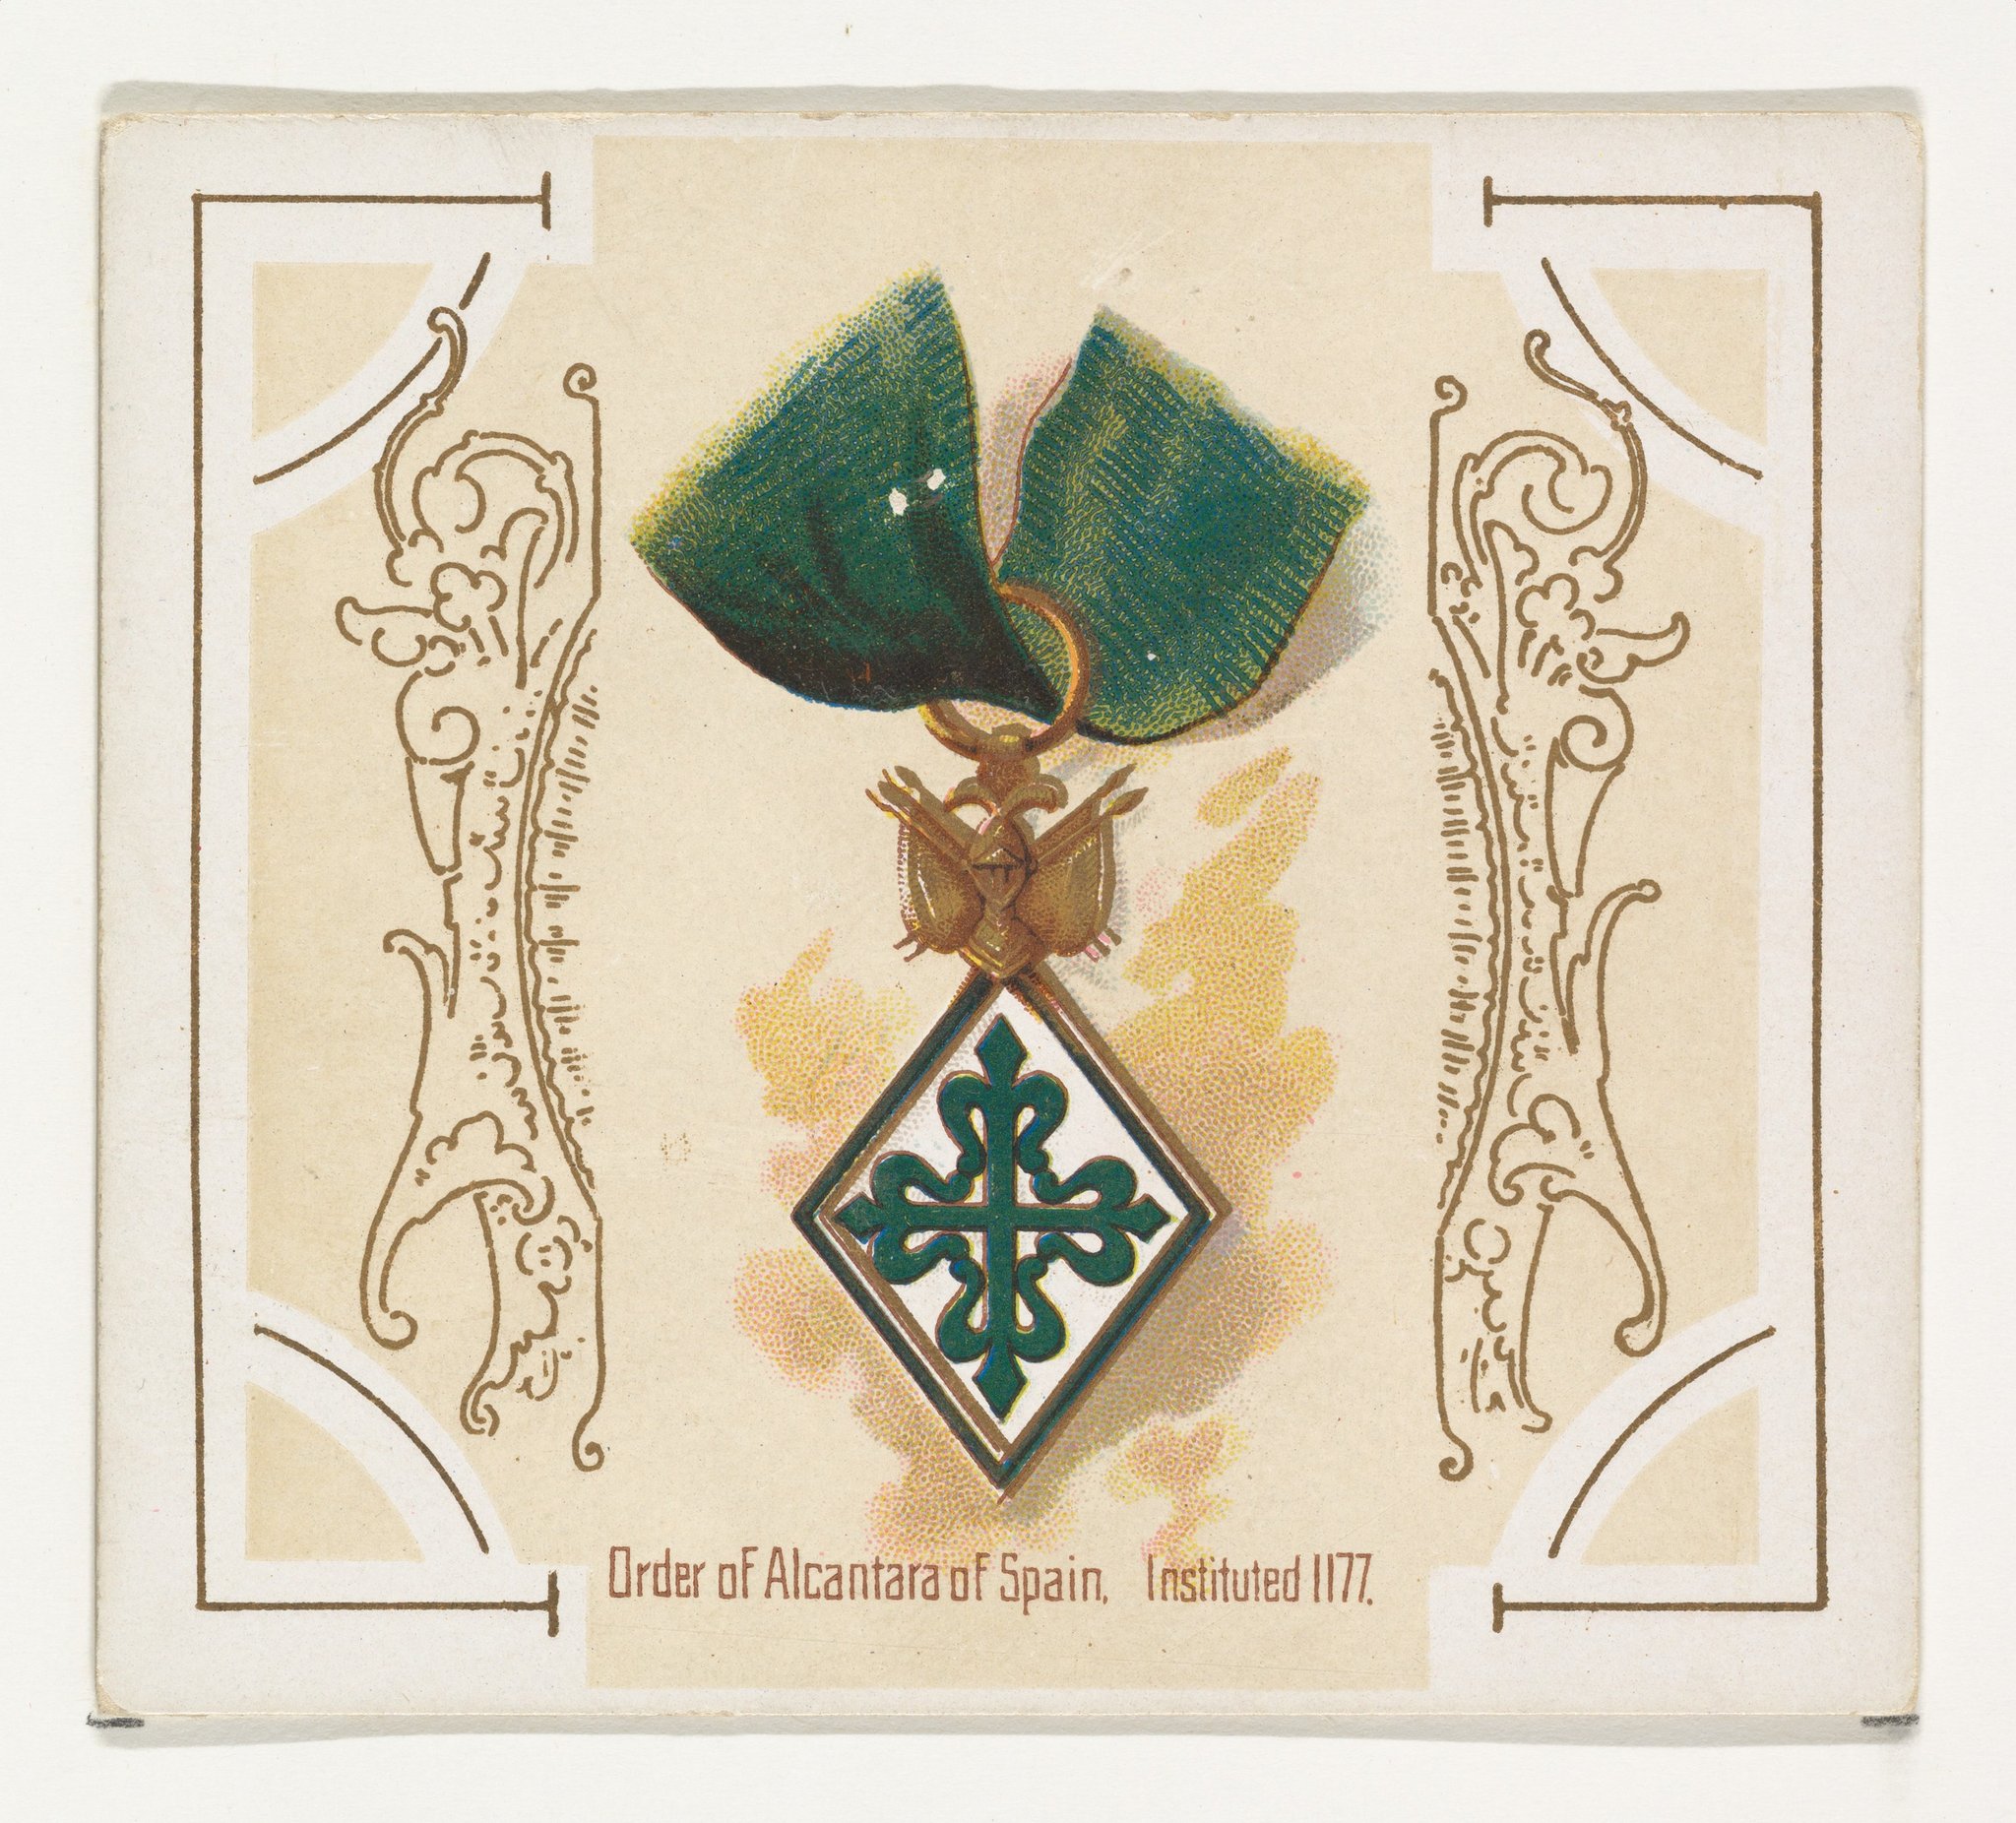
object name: print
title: Order of Alcantara of Spain, Instituted 1177, from the World's Decorations series (N44) for Allen & Ginter Cigarettes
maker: allen & ginter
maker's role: publisher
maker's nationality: american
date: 1890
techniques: color lithograph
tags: medals